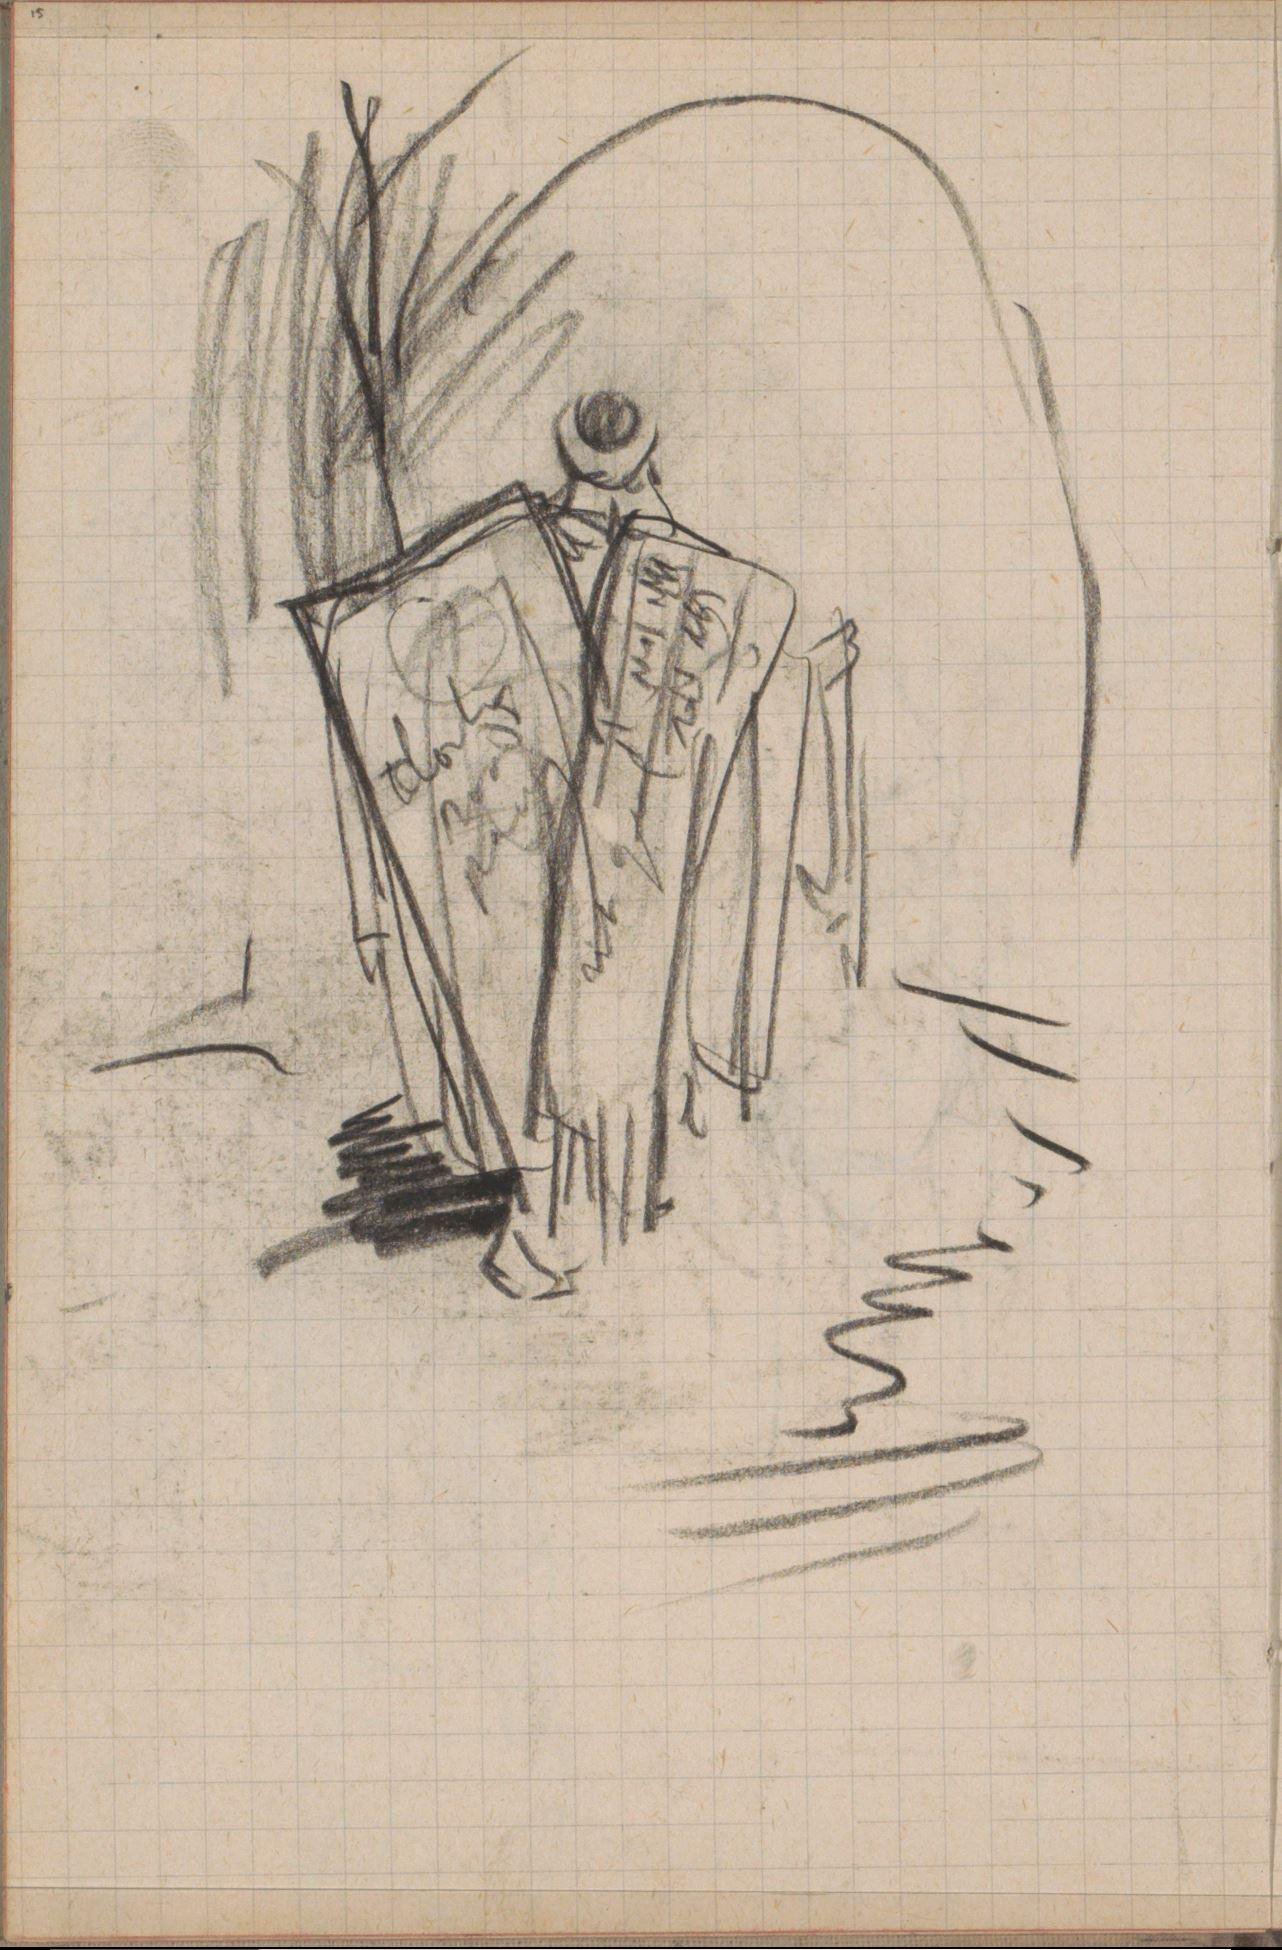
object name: sketchbook leaf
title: Figuur met staf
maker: marius bauer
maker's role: draughtsman, print maker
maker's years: 1867-1932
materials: chalk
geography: istanbul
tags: asiatic races and peoples, walking-stick, staff, arch, archivolt ~ architecture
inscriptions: kleurnotitie, handgeschreven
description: Achteraanzicht van een figuur bij een poort in oosterse kleding. Pagina 15 uit een schetsboek met 51 bladen.